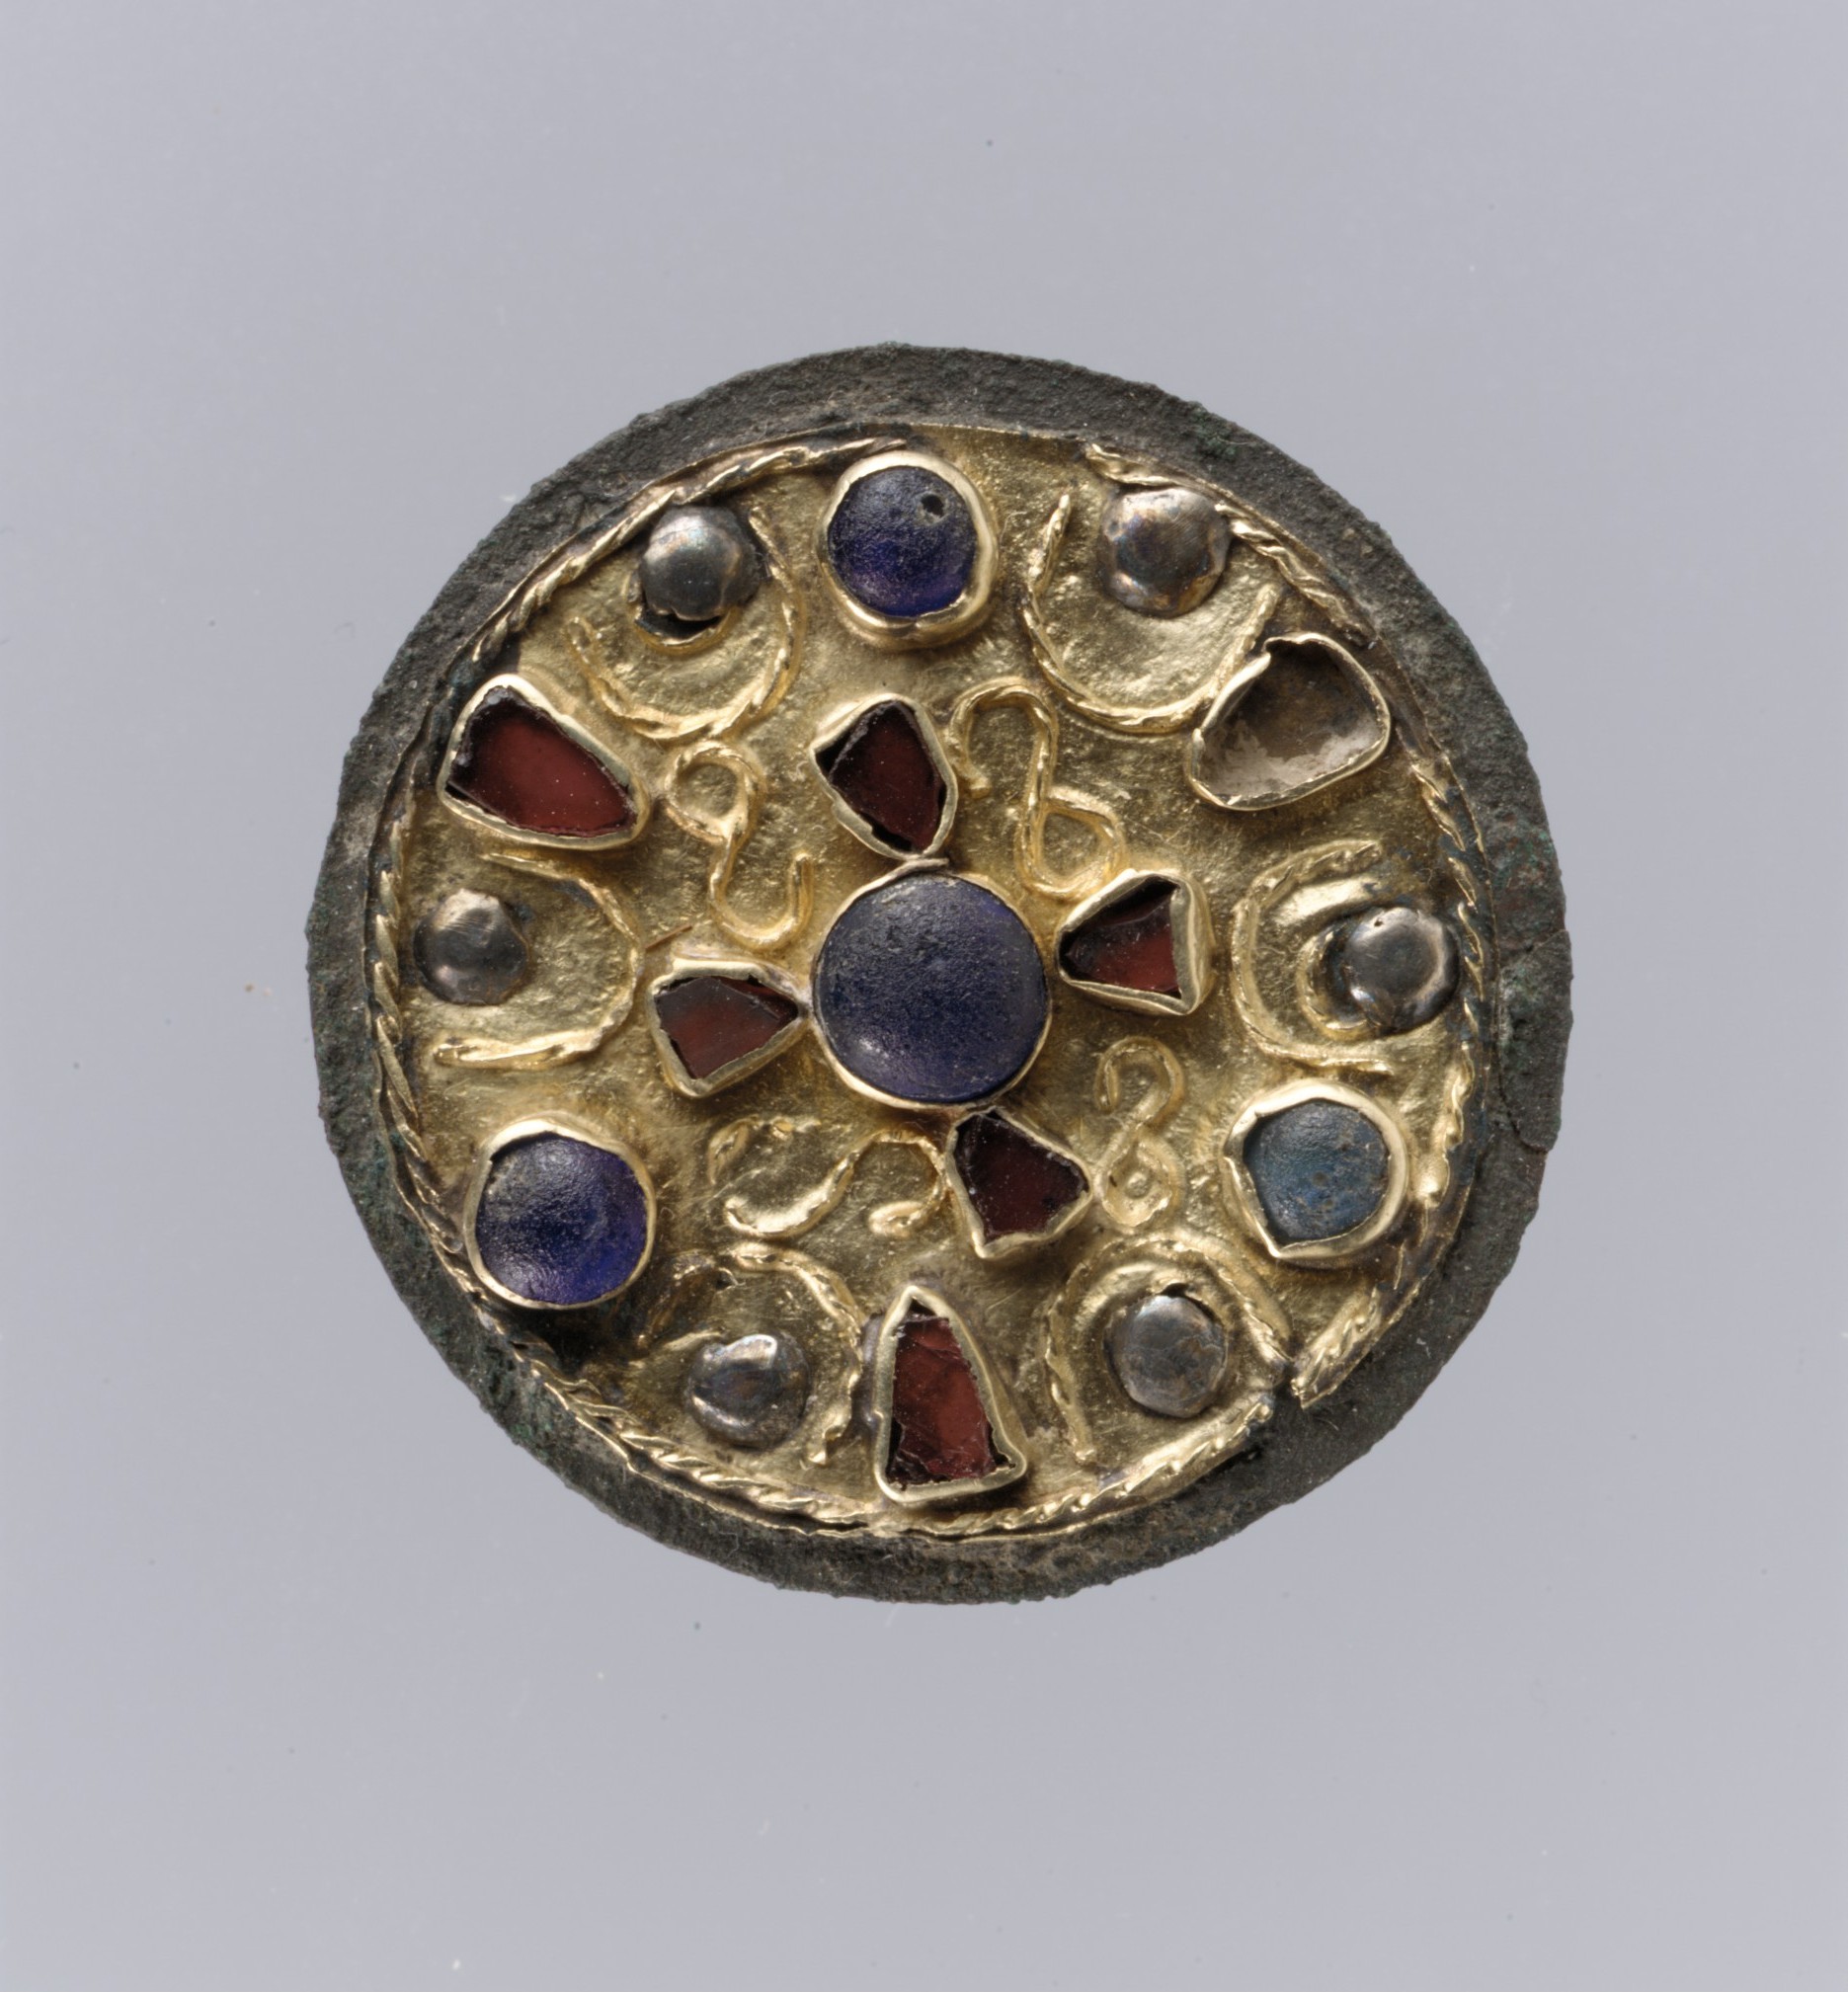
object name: brooch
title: Disk Brooch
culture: frankish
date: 601-700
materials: copper alloy, garnet, glass, gold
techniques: filigree